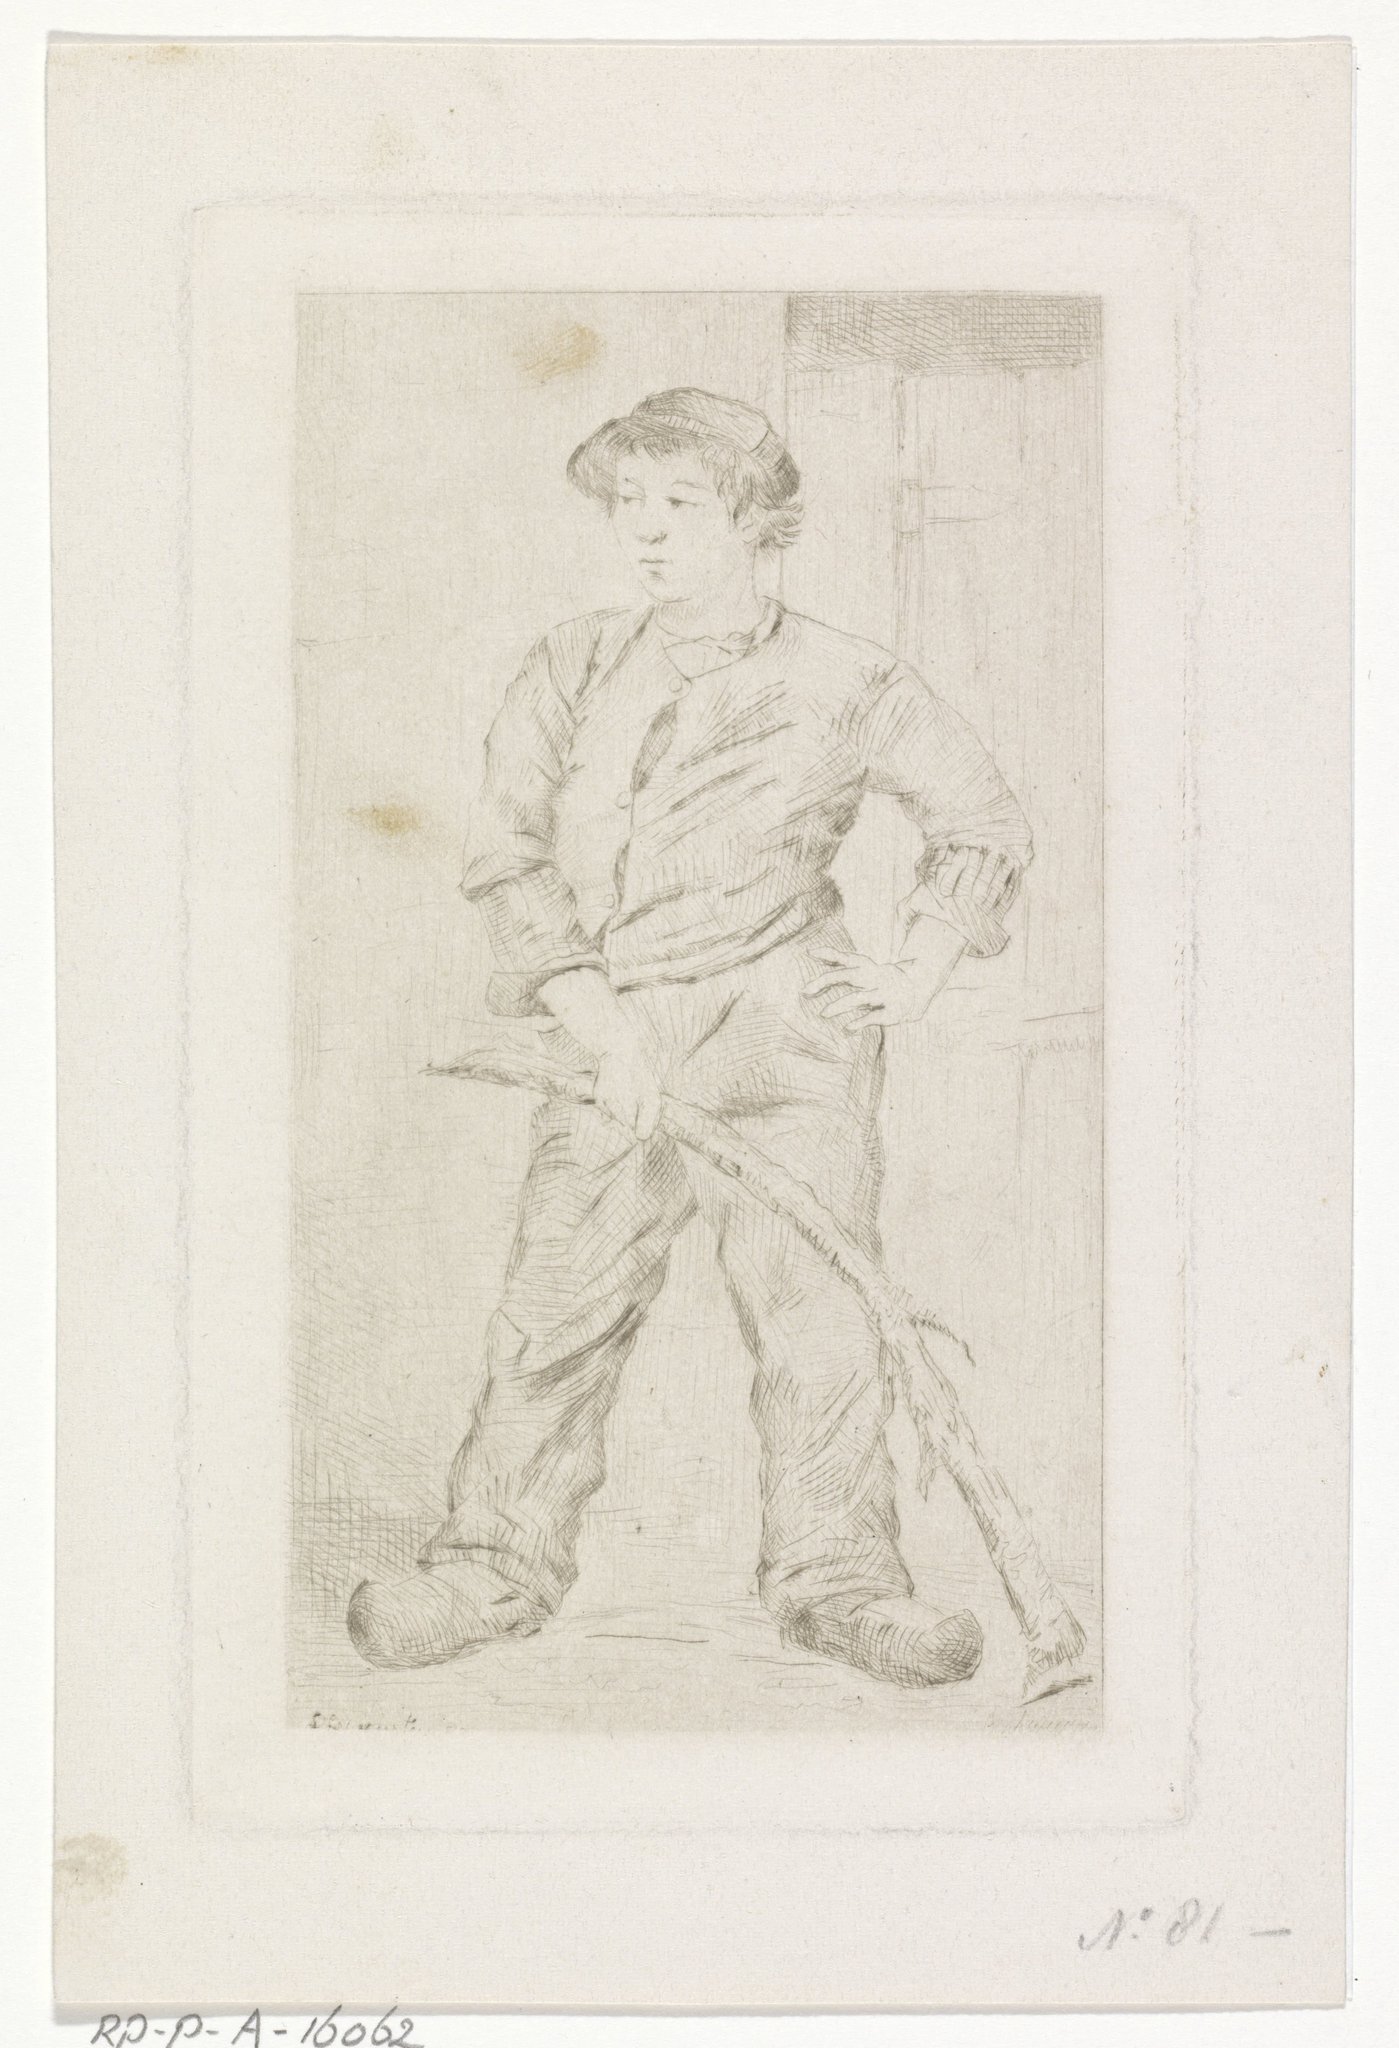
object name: print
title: Staande boerenjongen op klompen met een tak in zijn hand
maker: Anonymous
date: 1800-1890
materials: paper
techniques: drypoint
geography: netherlands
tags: wooden shoes, clogs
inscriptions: collector's mark: Lugt 2228